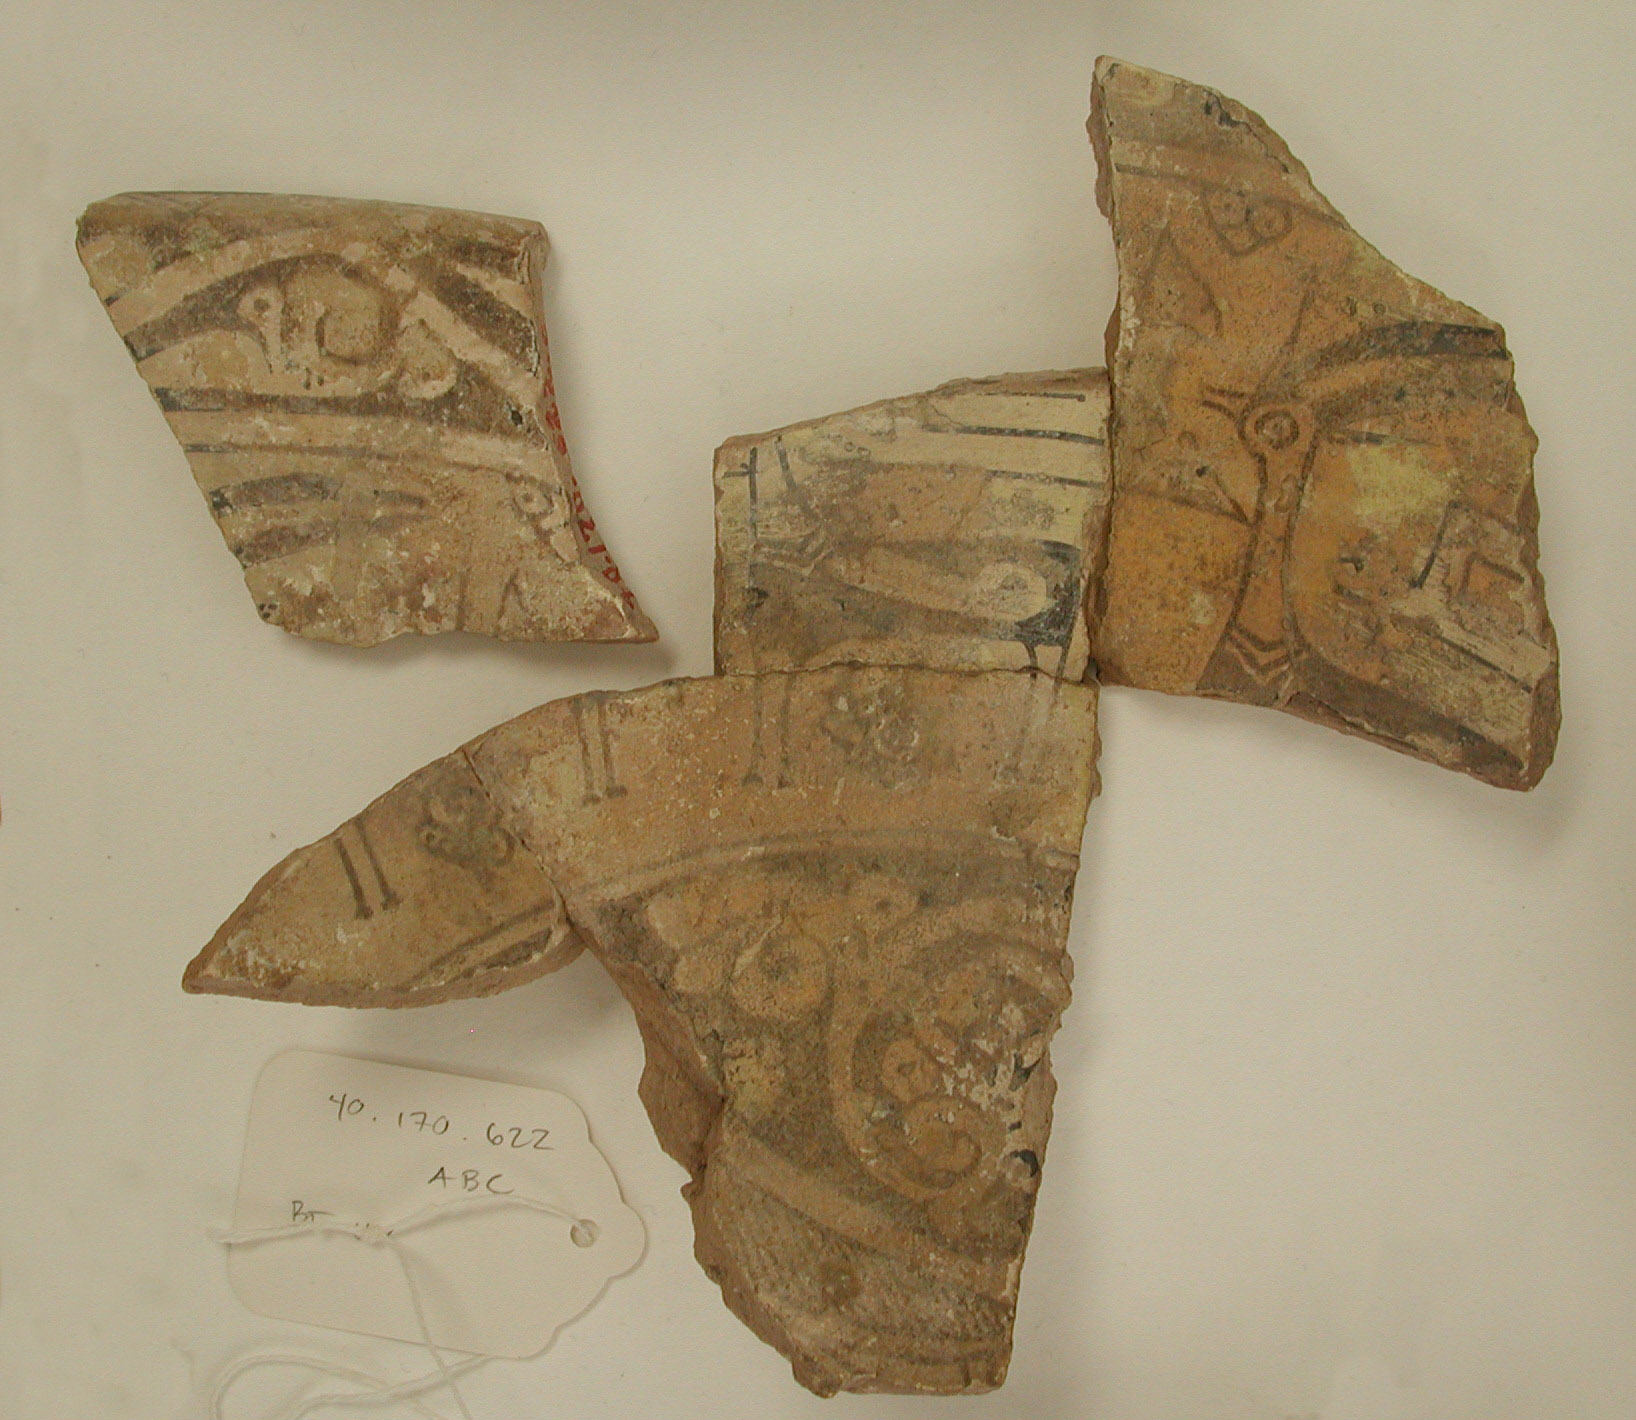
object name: fragment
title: Fragments of a Bowl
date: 801-1000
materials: earthenware, glaze, pigment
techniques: painting, polychrome, underglaze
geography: iran